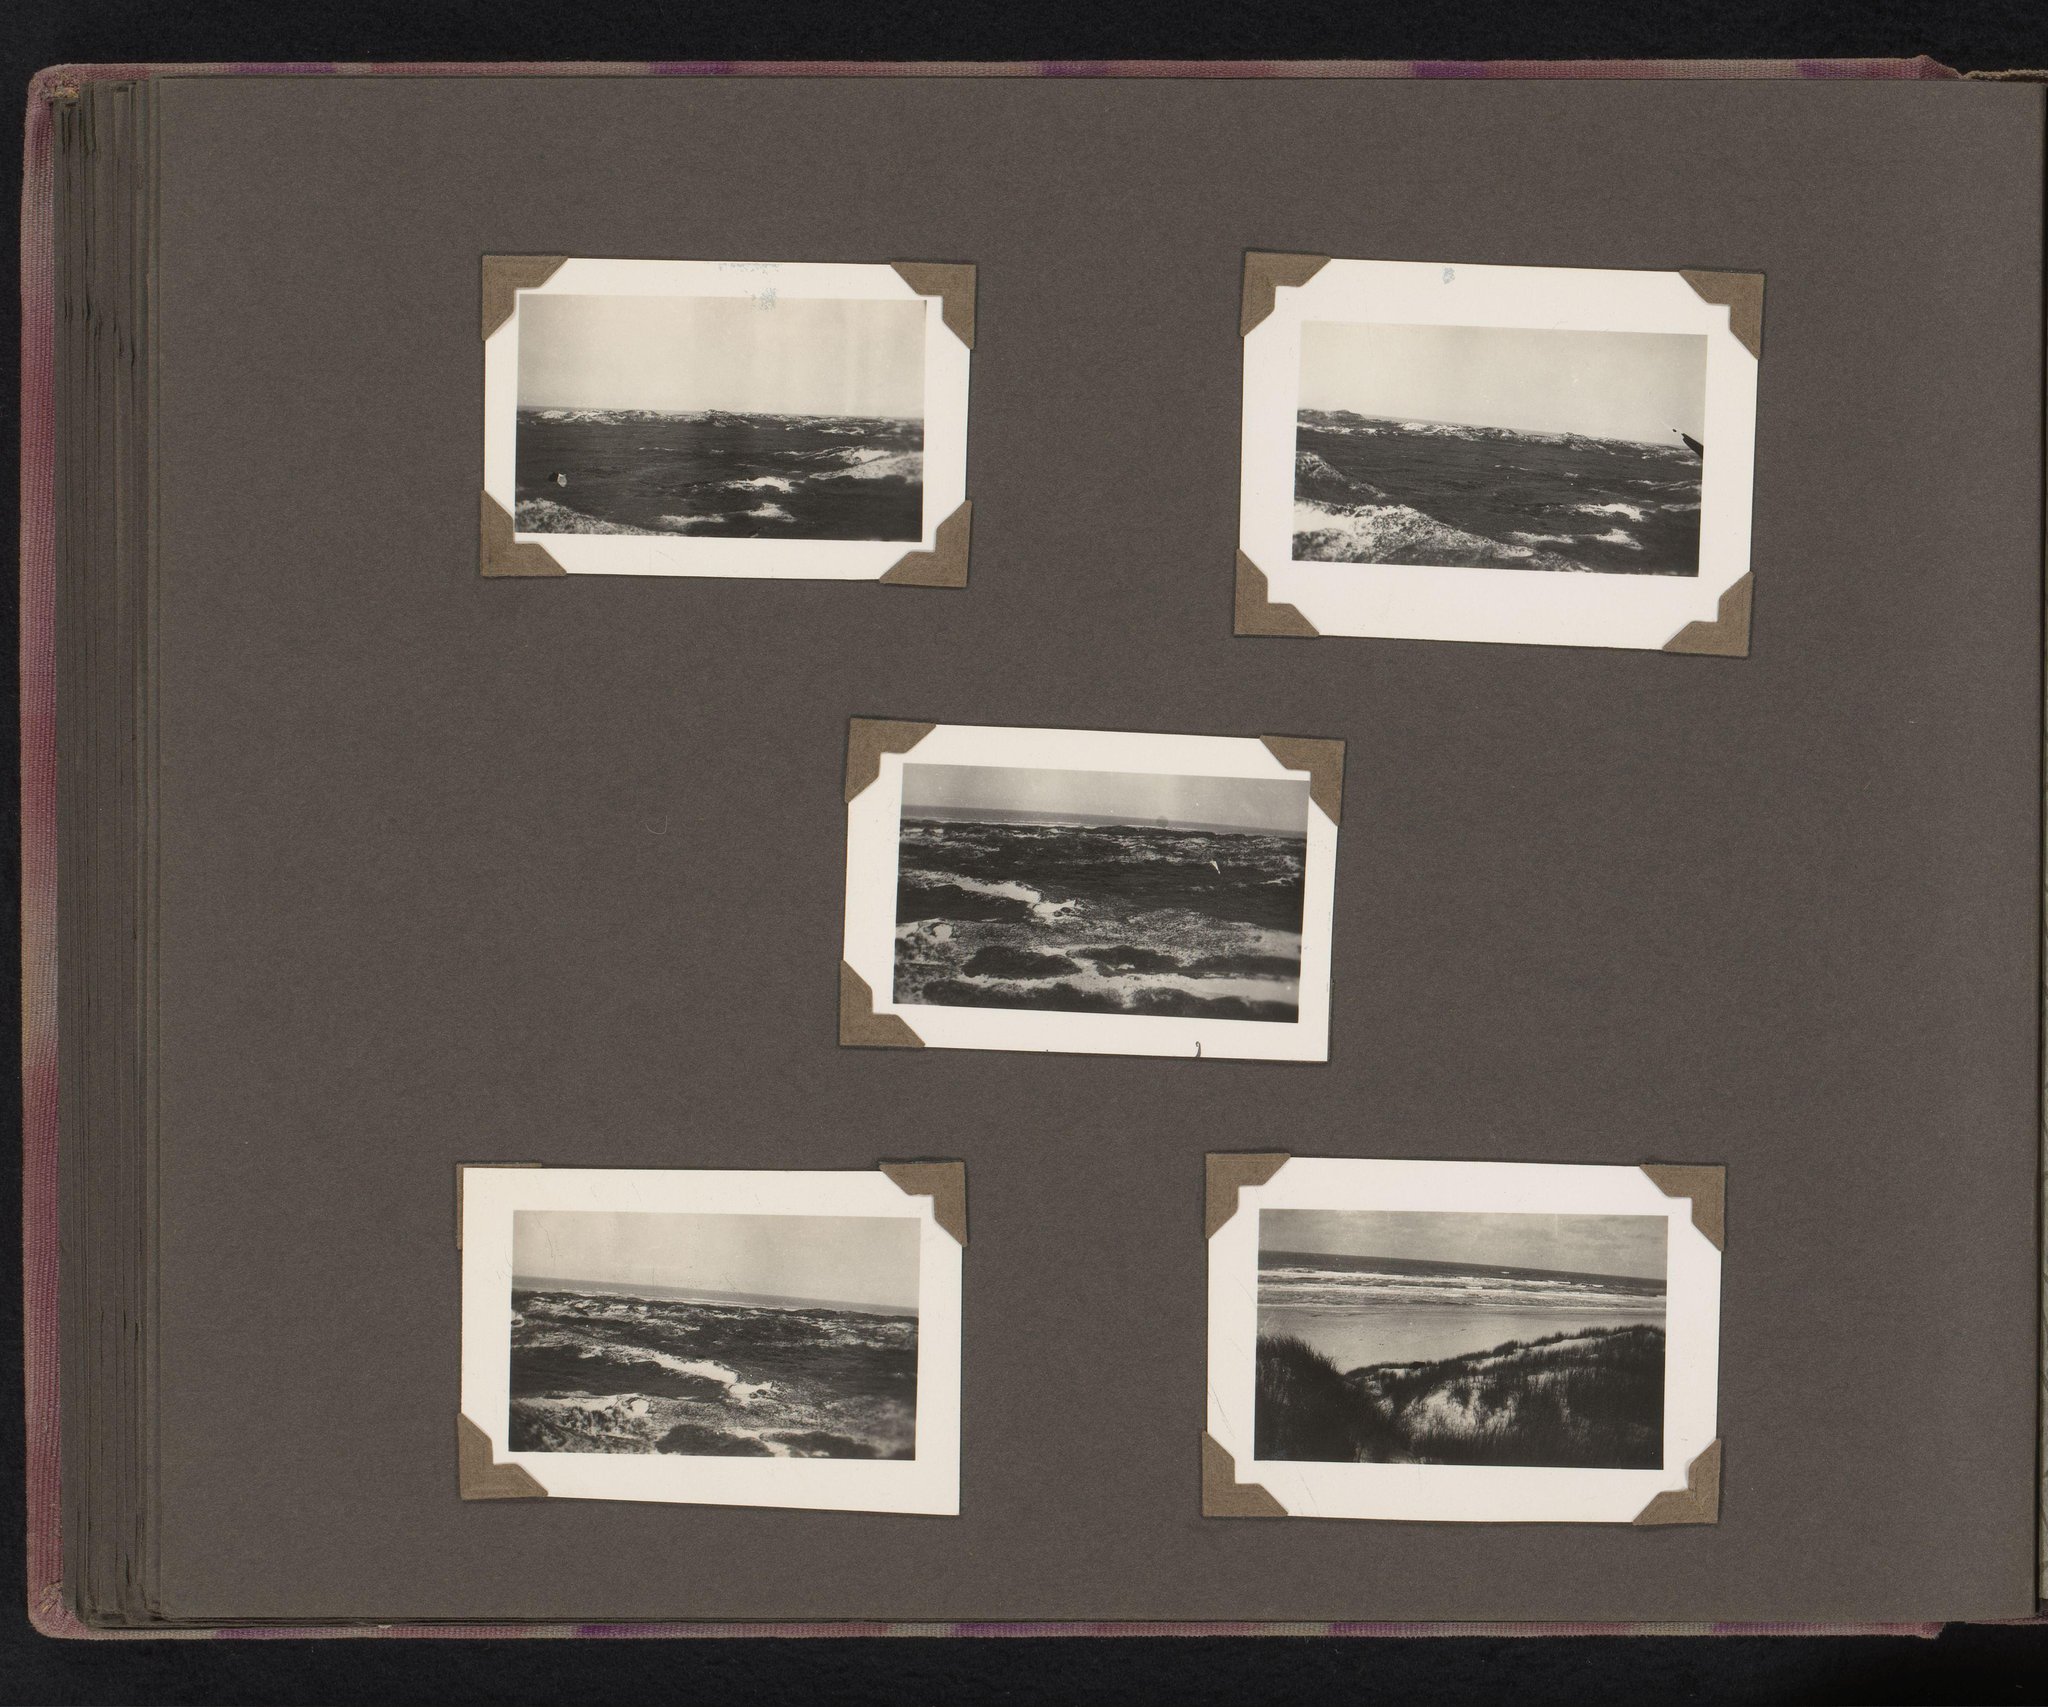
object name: photograph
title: Vijf duinlandschappen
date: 1930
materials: cardboard, photographic support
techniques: gelatin silver print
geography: texel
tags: dune coast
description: De foto's zijn gemaakt tijdens een bezoek aan een Waddeneiland, vermoedelijk Texel. Deze foto's maken deel uit van een album.